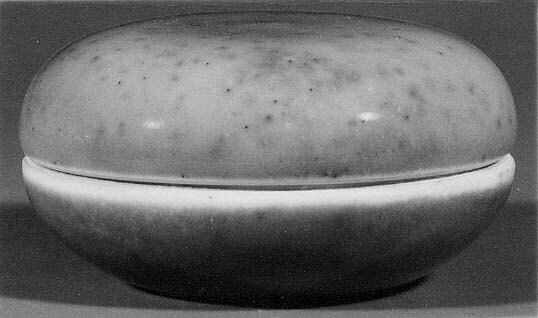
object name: box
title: Rouge Box with Cover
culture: chinese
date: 1600-1800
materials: glaze, porcelain